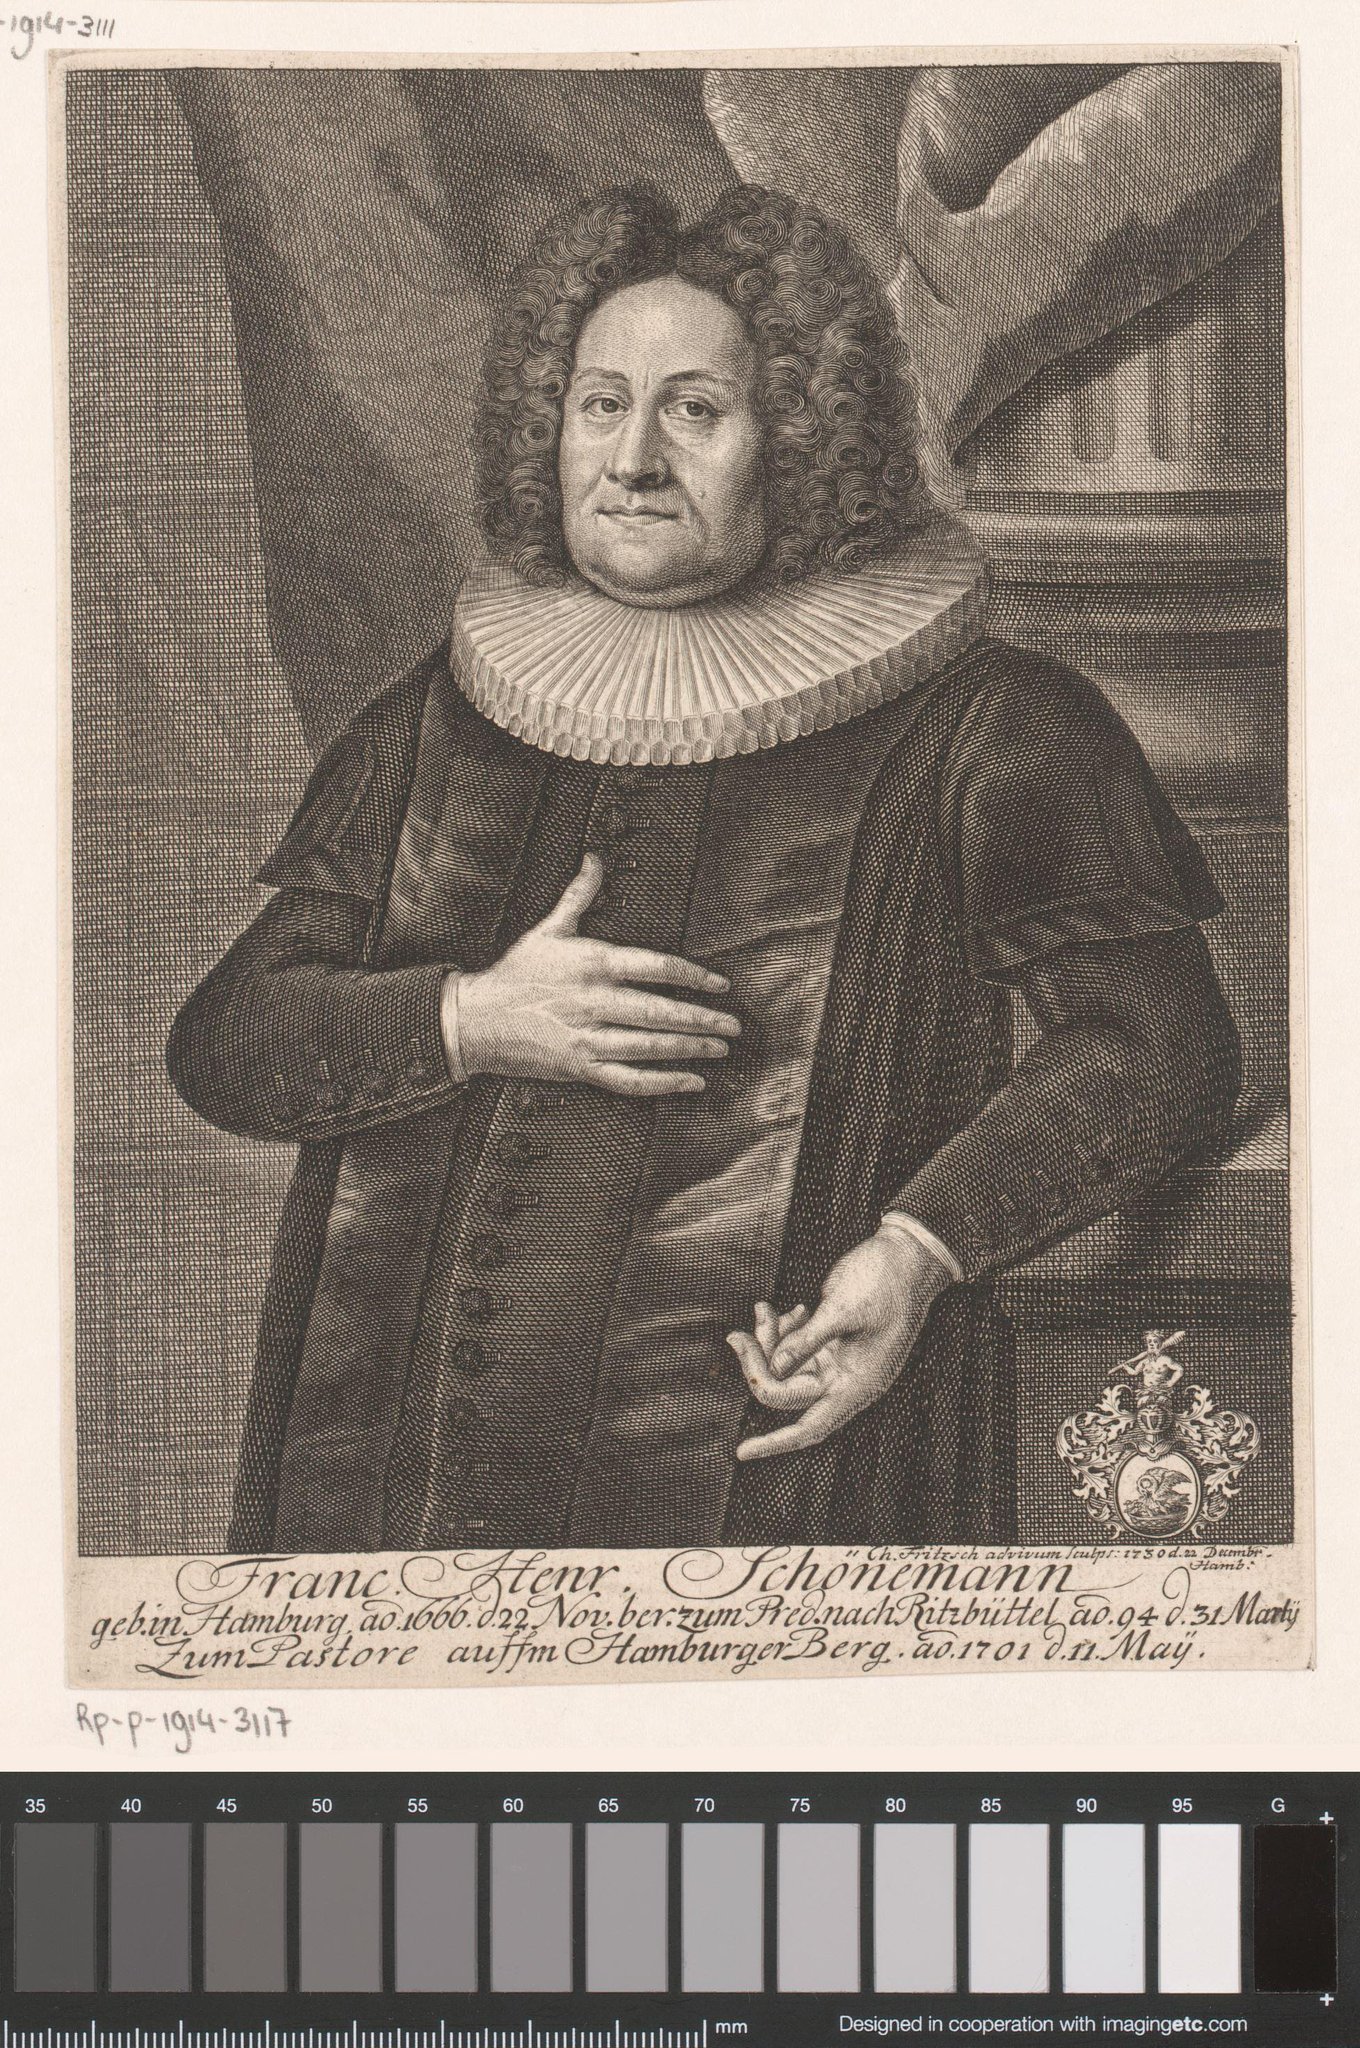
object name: print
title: Portret van Franz Heinrich Schönemann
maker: christian fritzsch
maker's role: print maker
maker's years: 1695-1769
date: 1730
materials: paper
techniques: engraving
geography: hamburg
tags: bookshelves, historical persons, armorial bearing, heraldry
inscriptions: collector's mark: Lugt 2228